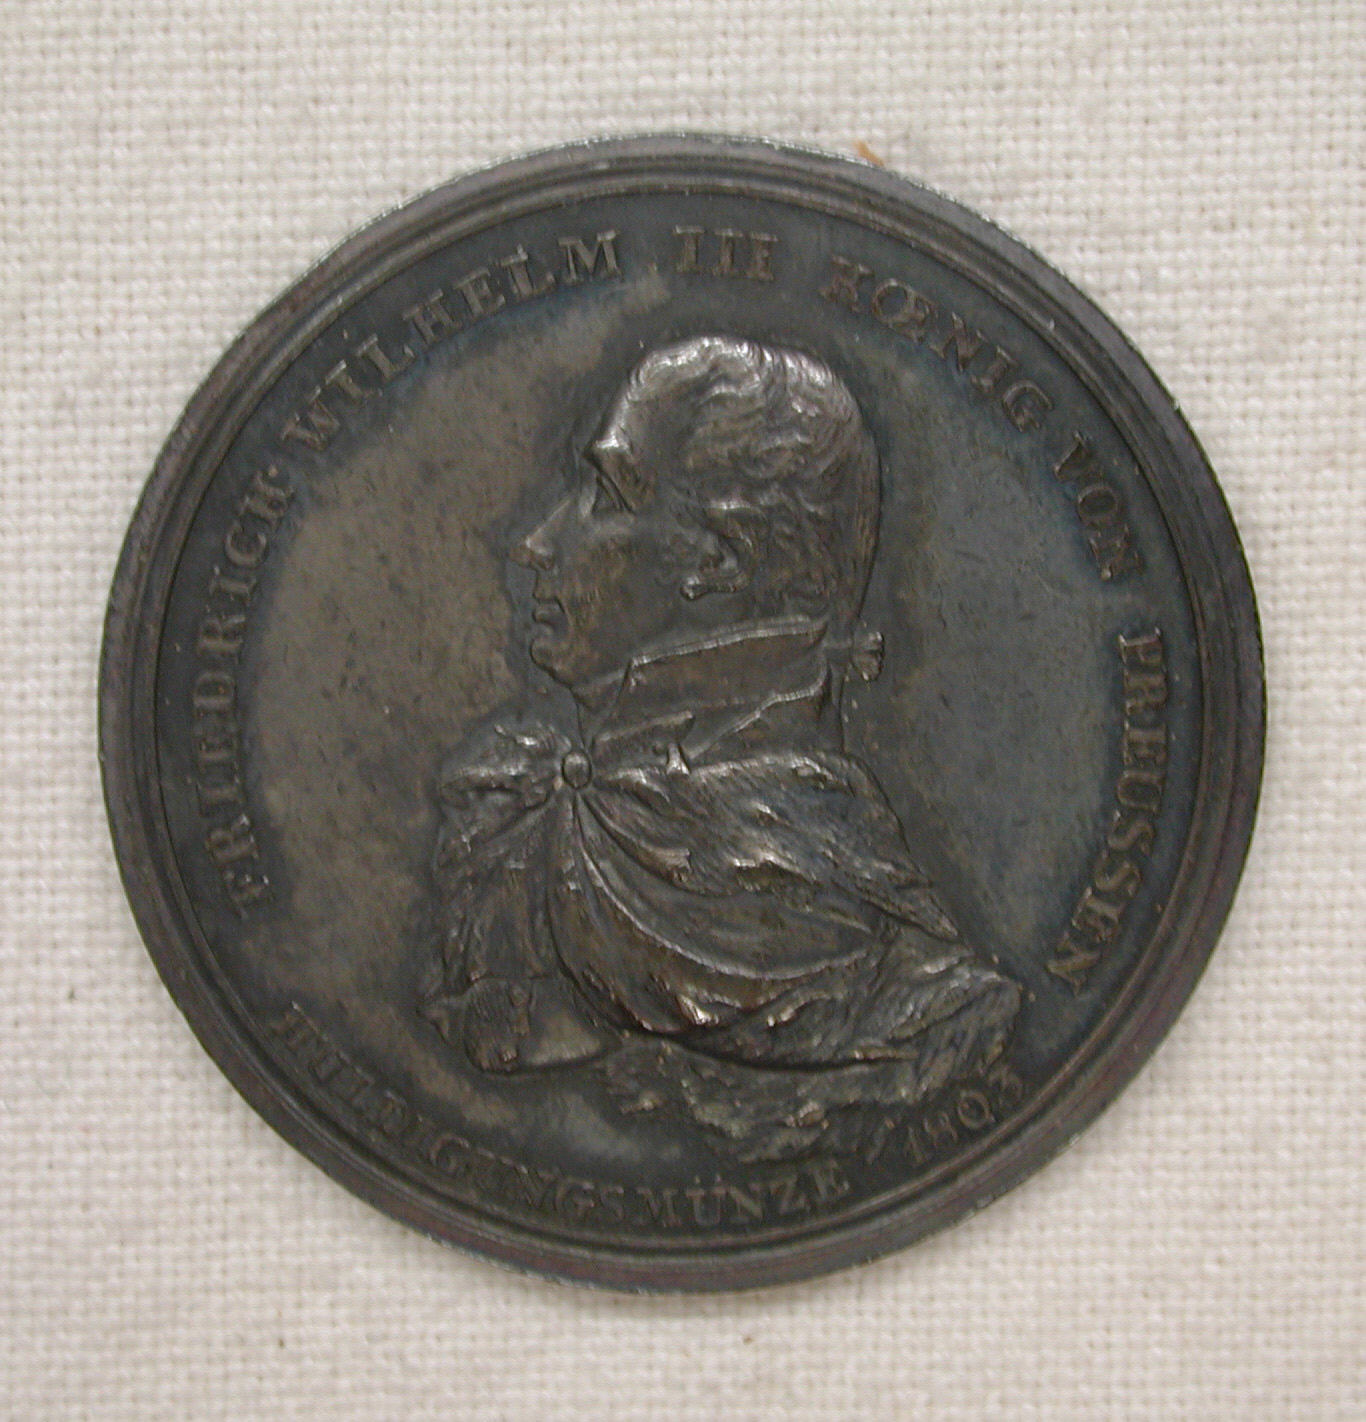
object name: medal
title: The Annexation of Erfurth to Prussia, 1803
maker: daniel friedrich loos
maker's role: artist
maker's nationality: german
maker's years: 1735-1819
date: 1803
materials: silver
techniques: struck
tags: men,profiles